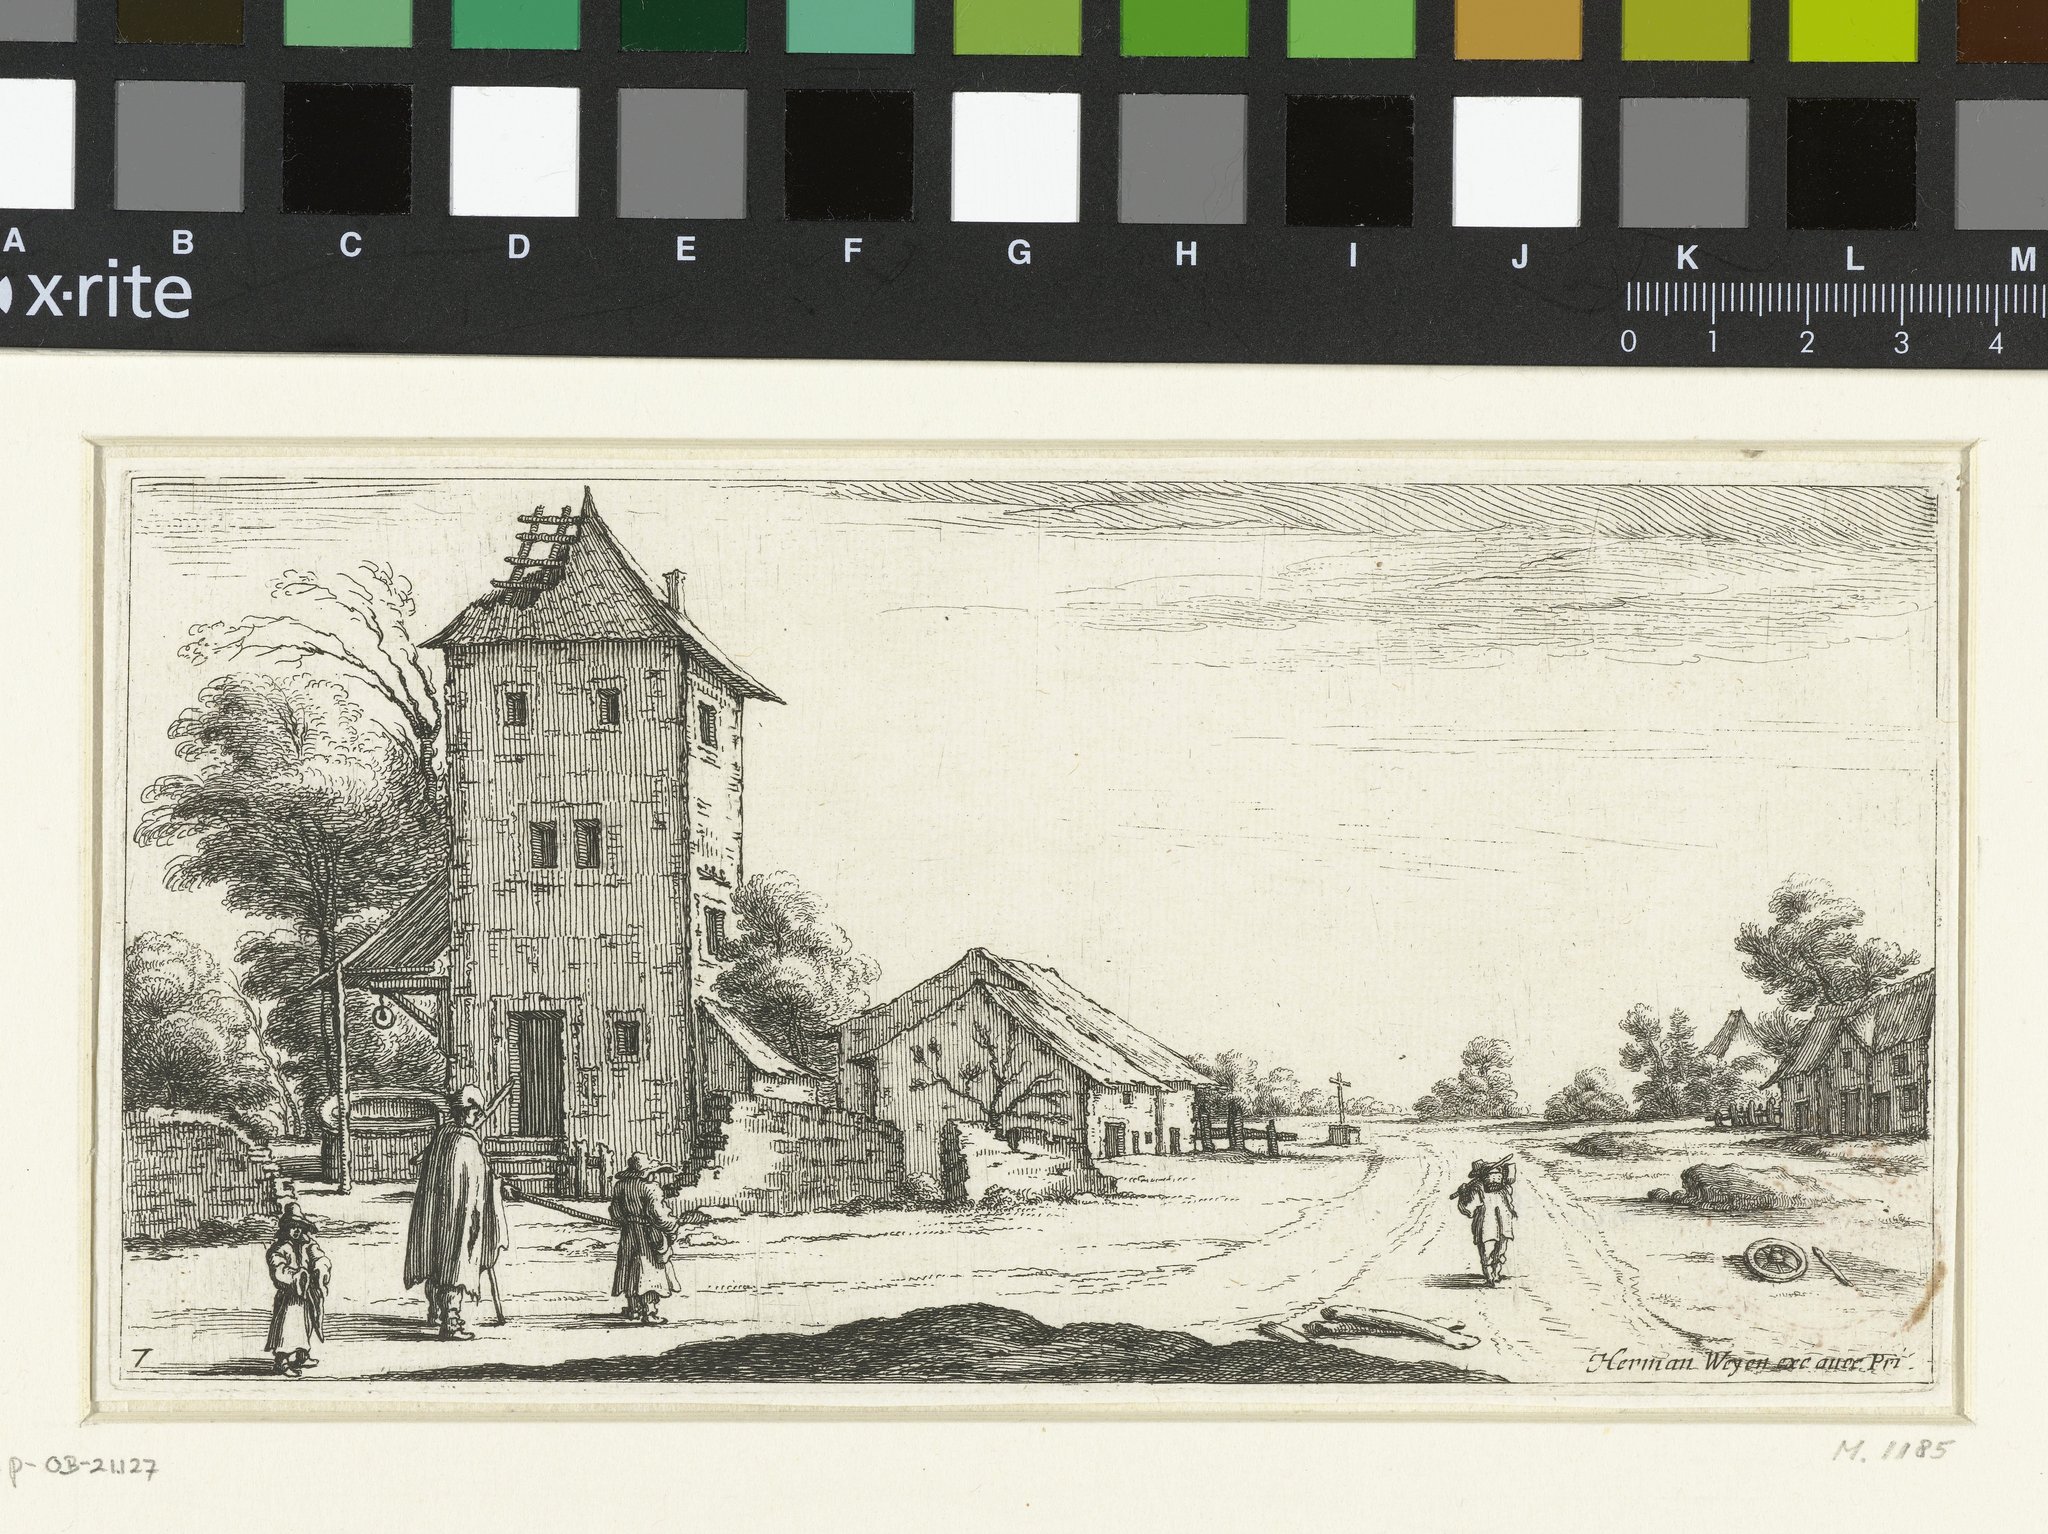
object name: print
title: Acht landschappen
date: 1621-1672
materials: paper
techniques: etching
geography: paris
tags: landscapes in the temperate zone, village street, tower (of house or building)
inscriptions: collector's mark: Lugt 240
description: Weg door een dorp, met links een toren met een gat in het dak. Her en der figuurtjes, onder wie een man met twee kinderen. Deze prent is onderdeel van een serie van 8 (op de eerste prent na) genummerde prenten met landschappen.